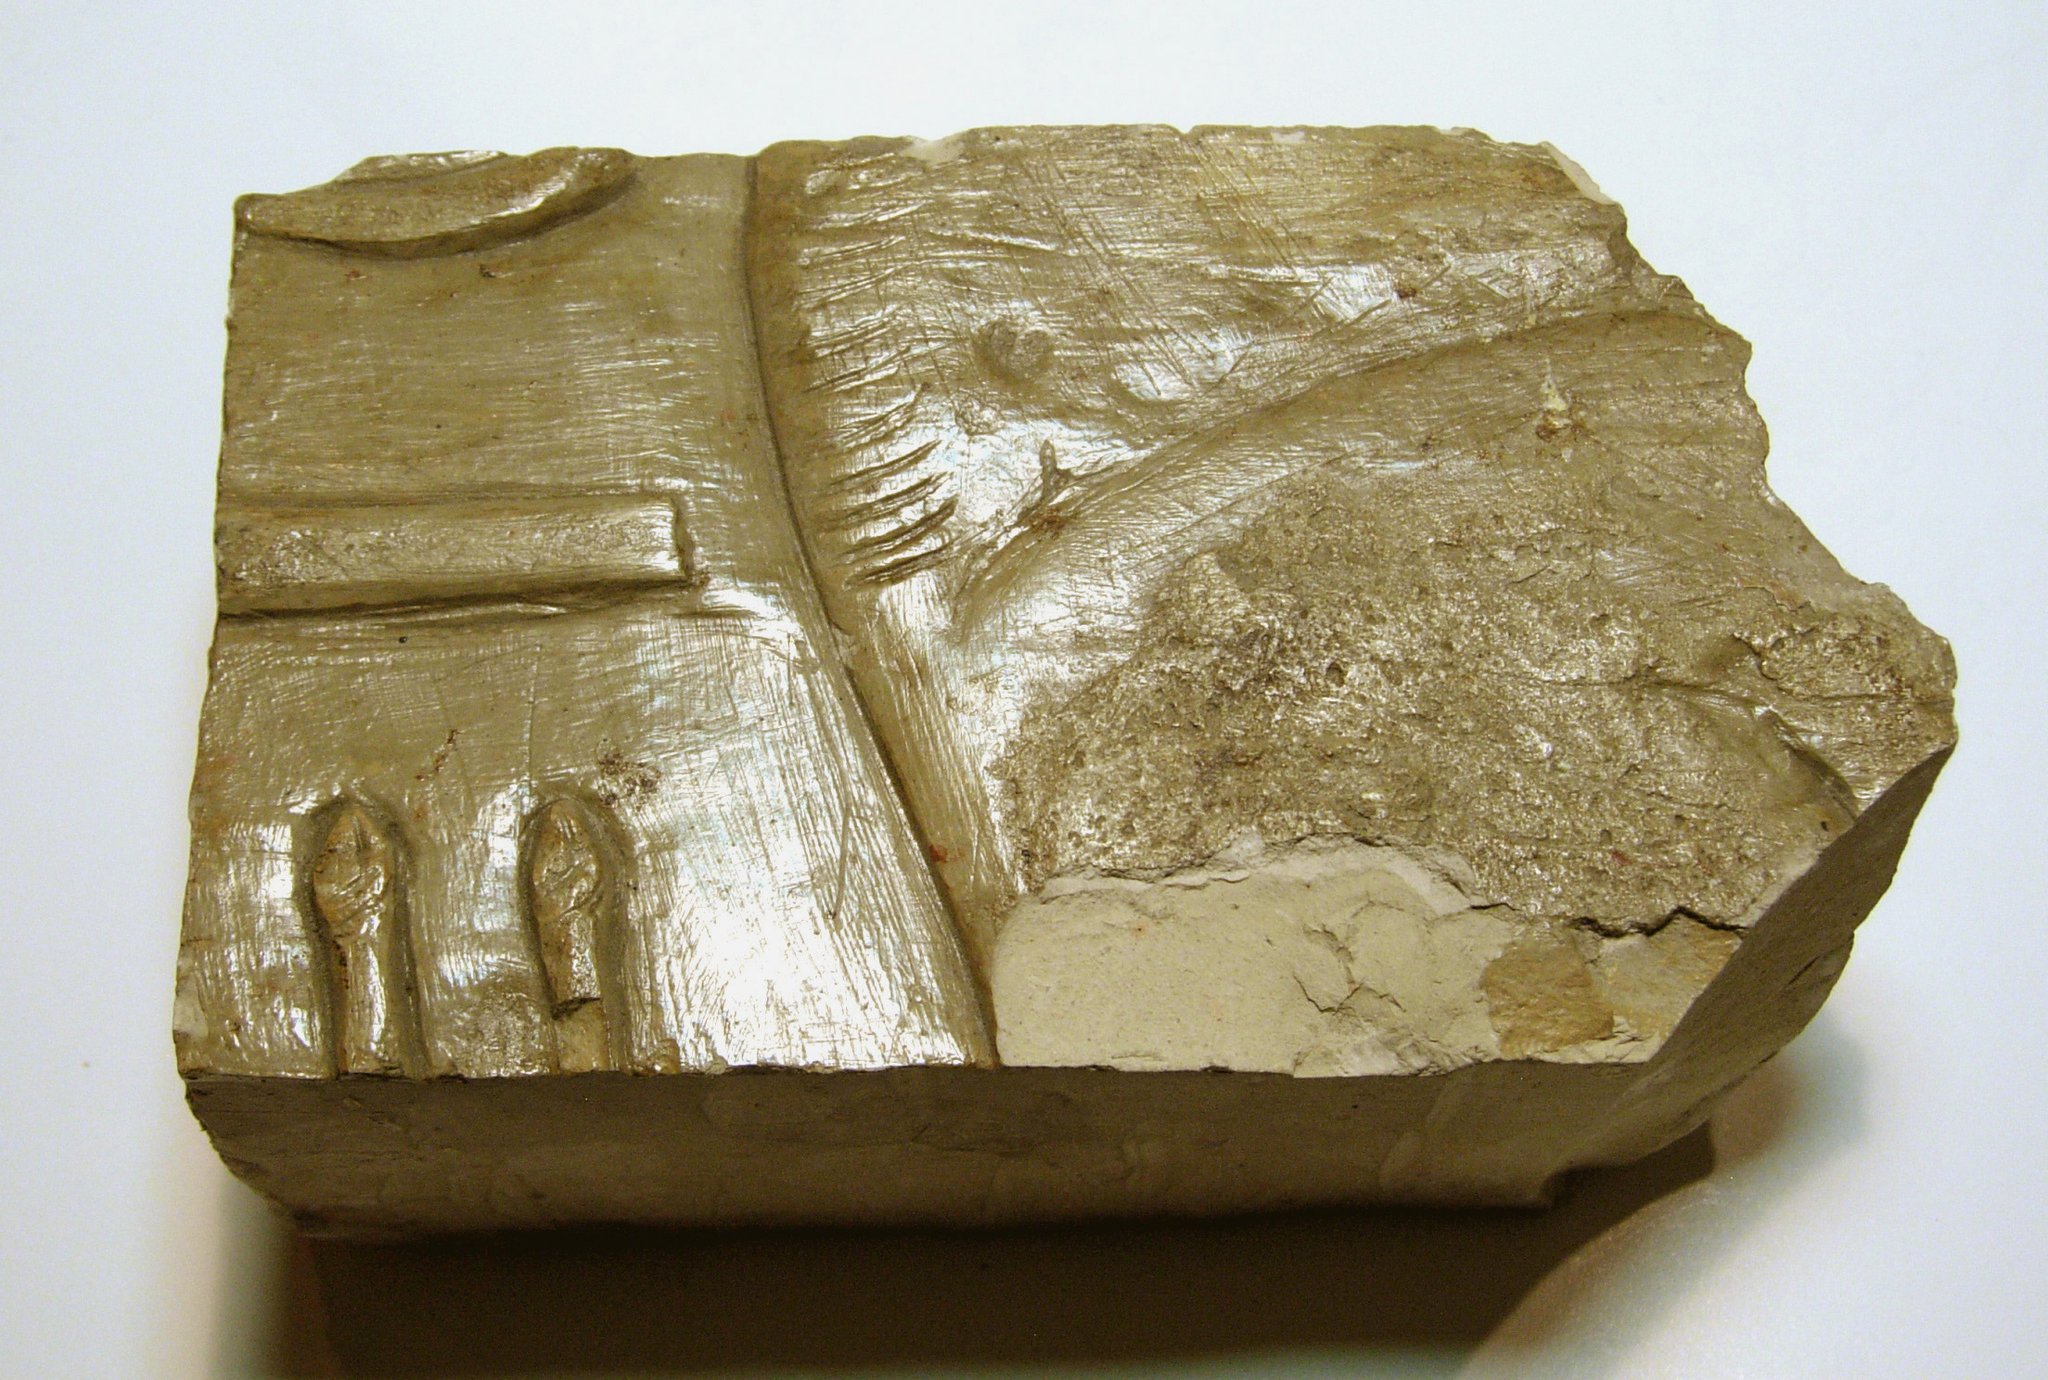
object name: relief, tomb of nespekashuty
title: Raised relief fragment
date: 664-610 BCE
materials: limestone, varnish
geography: egypt